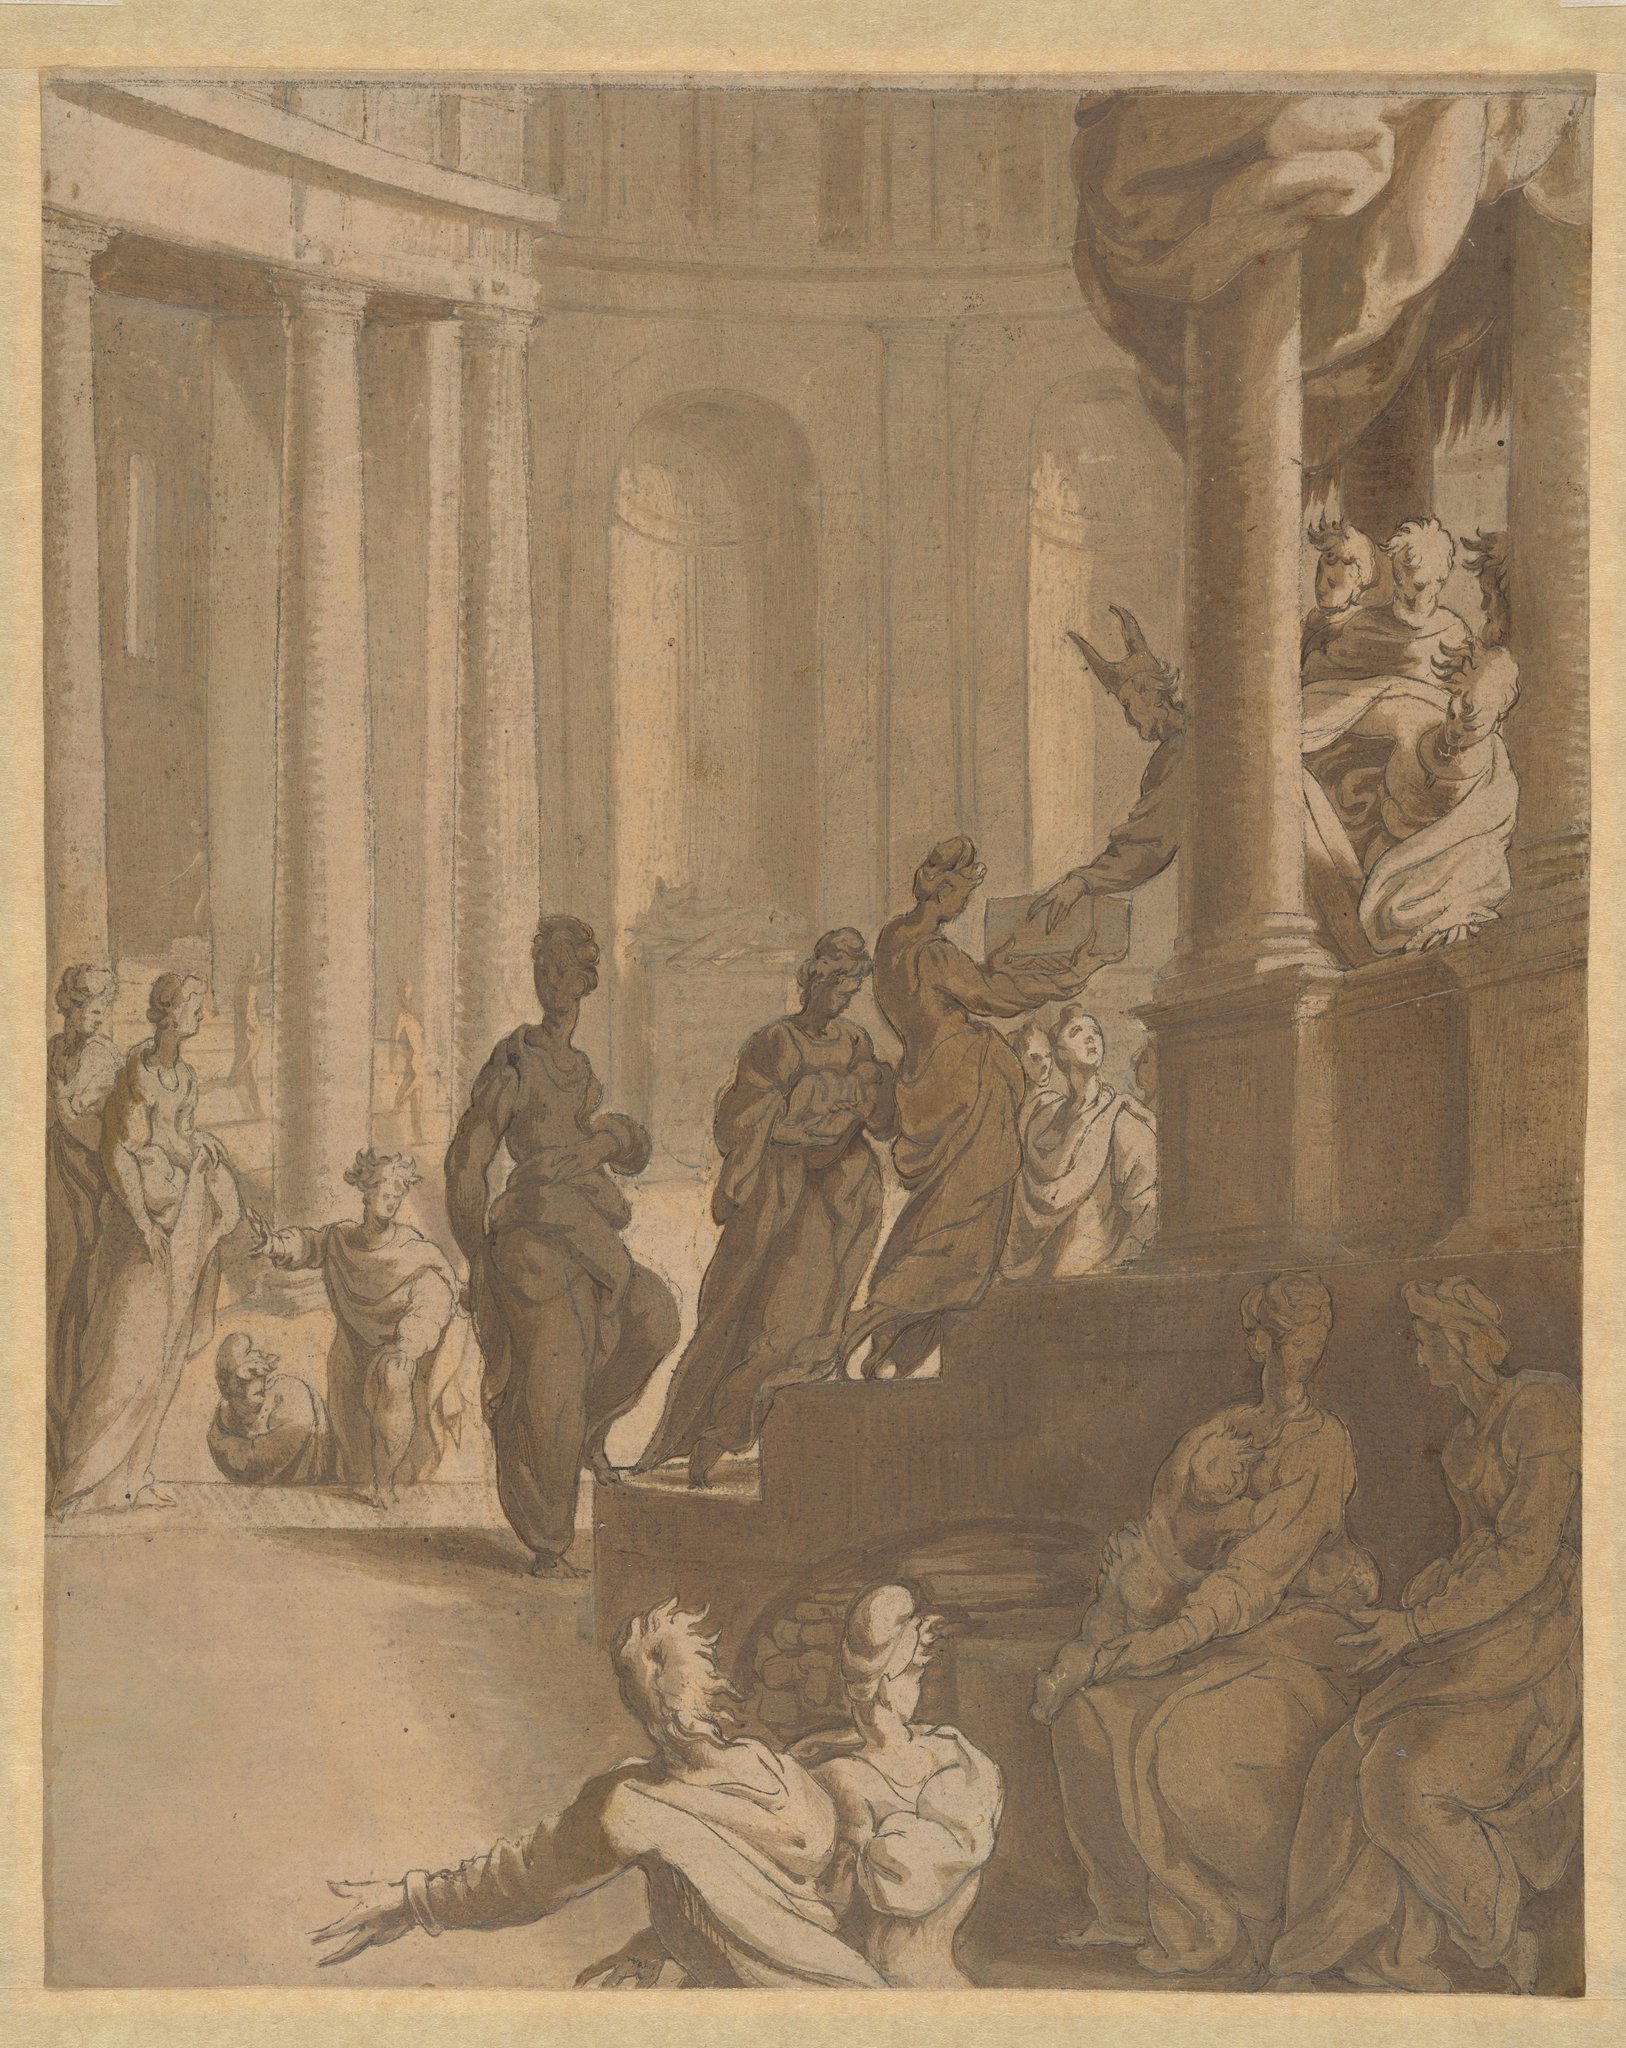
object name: drawing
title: The Purification of the Virgin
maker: adriaan de weerdt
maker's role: draughtsman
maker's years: 1510-1590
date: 1573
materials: chalk, oil, paper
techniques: brush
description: Mary climbs up the stairs to make an offering at the Temple. This is part of the purification ritual, which was required by Jewish law after a woman gave birth. The drawing vividly demonstrates the influence of Italian art on De Weerdt. The slender, elongated figures and the interest in the effects of light and dark evoke the work of Francesco Mazzola (1503-1540), more commonly known as Parmigianino.